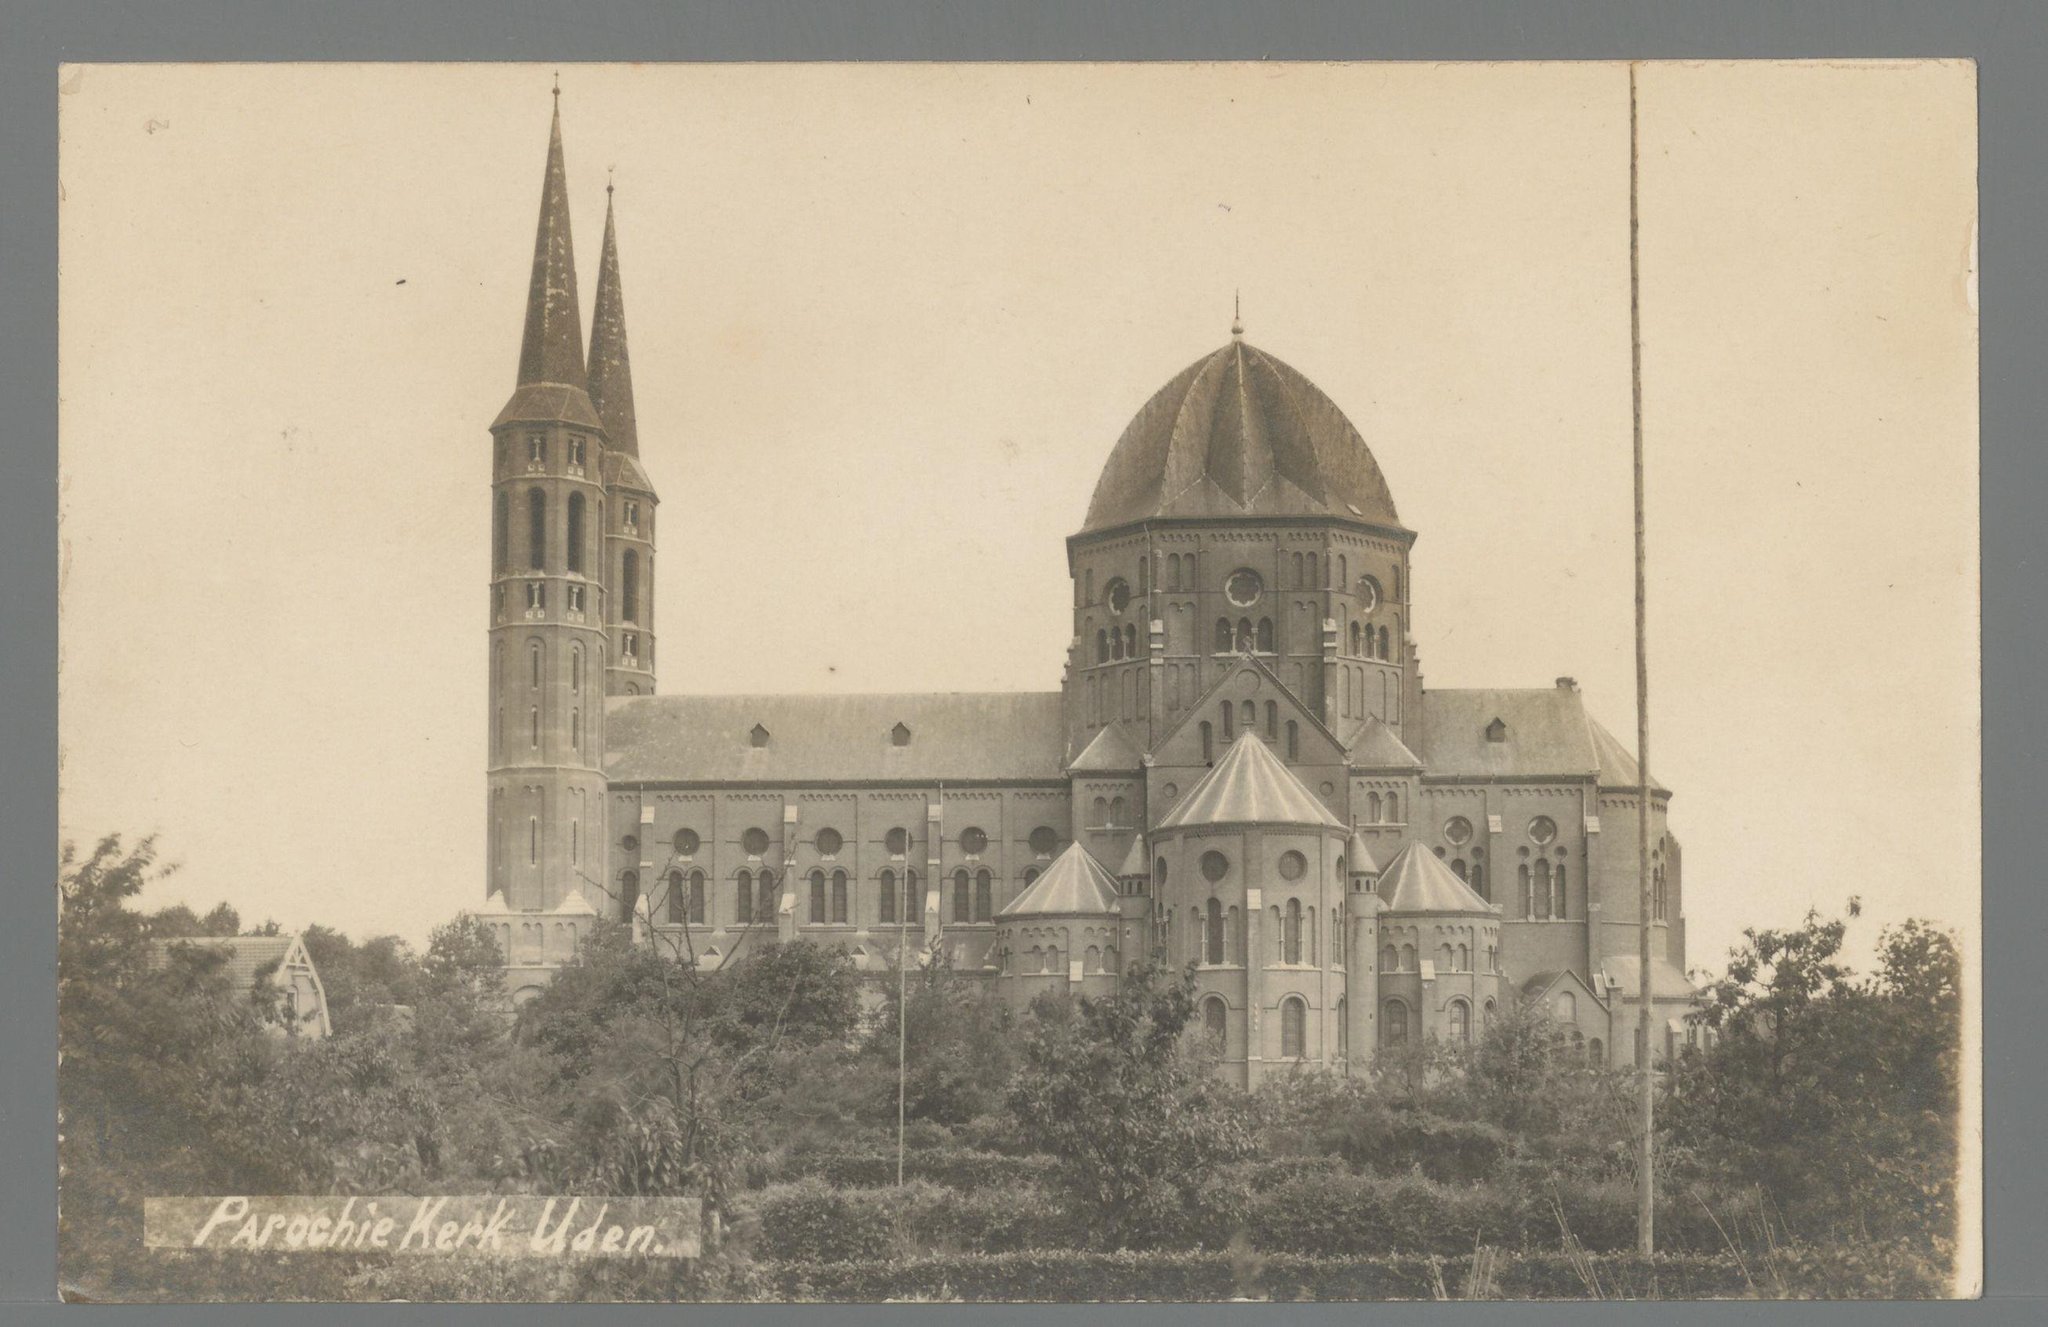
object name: photograph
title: Parochie Kerk Uden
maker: a. scheepens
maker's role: fotograaf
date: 1900-1930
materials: paper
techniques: gelatin silver print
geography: uden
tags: church (exterior)